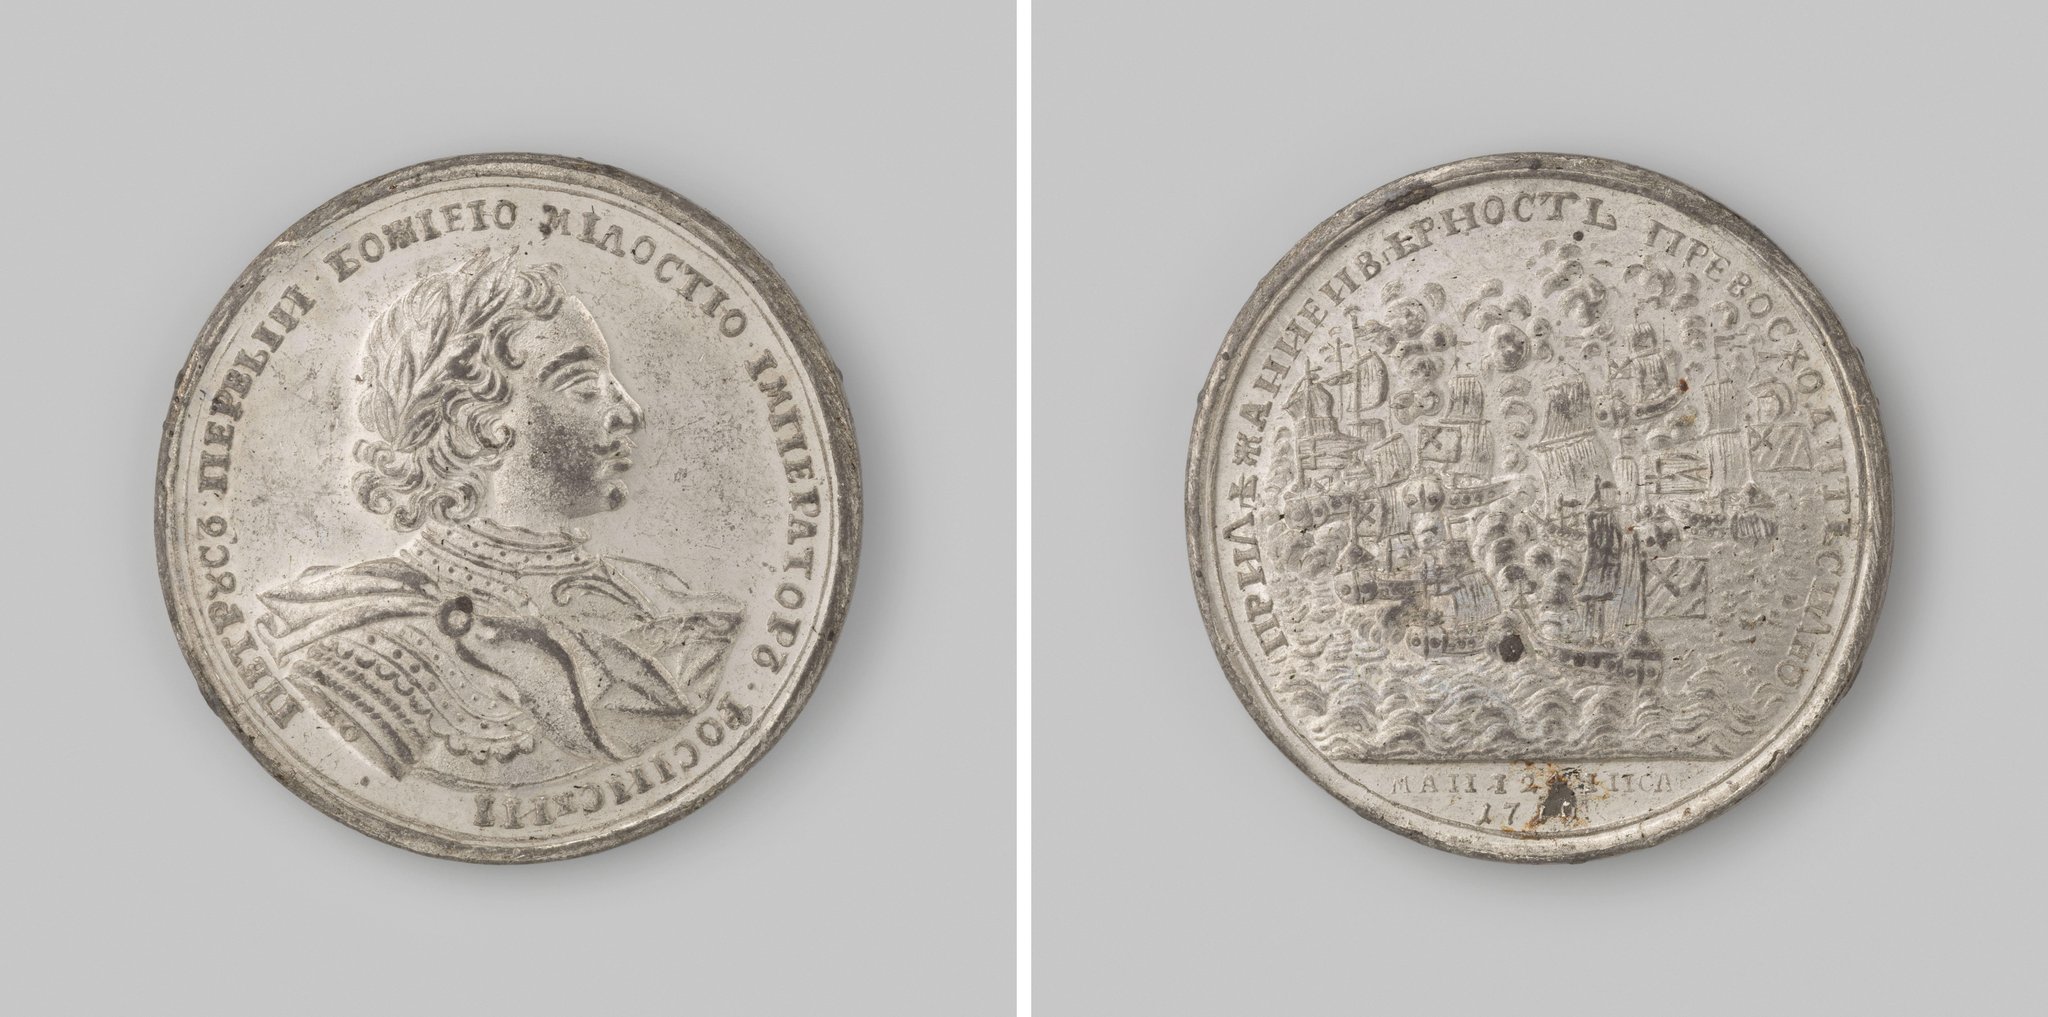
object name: history medal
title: Verovering van drie oorlogsschepen door Rusland op Zweden 1719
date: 1719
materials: tin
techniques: striking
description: Tinnen penning, op de voorzijde het borstbeeld van Tsaar Peter de Grote naar rechts met omschrift, op de keerzijde een zeegevecht met omschrift en afsnedetekst.